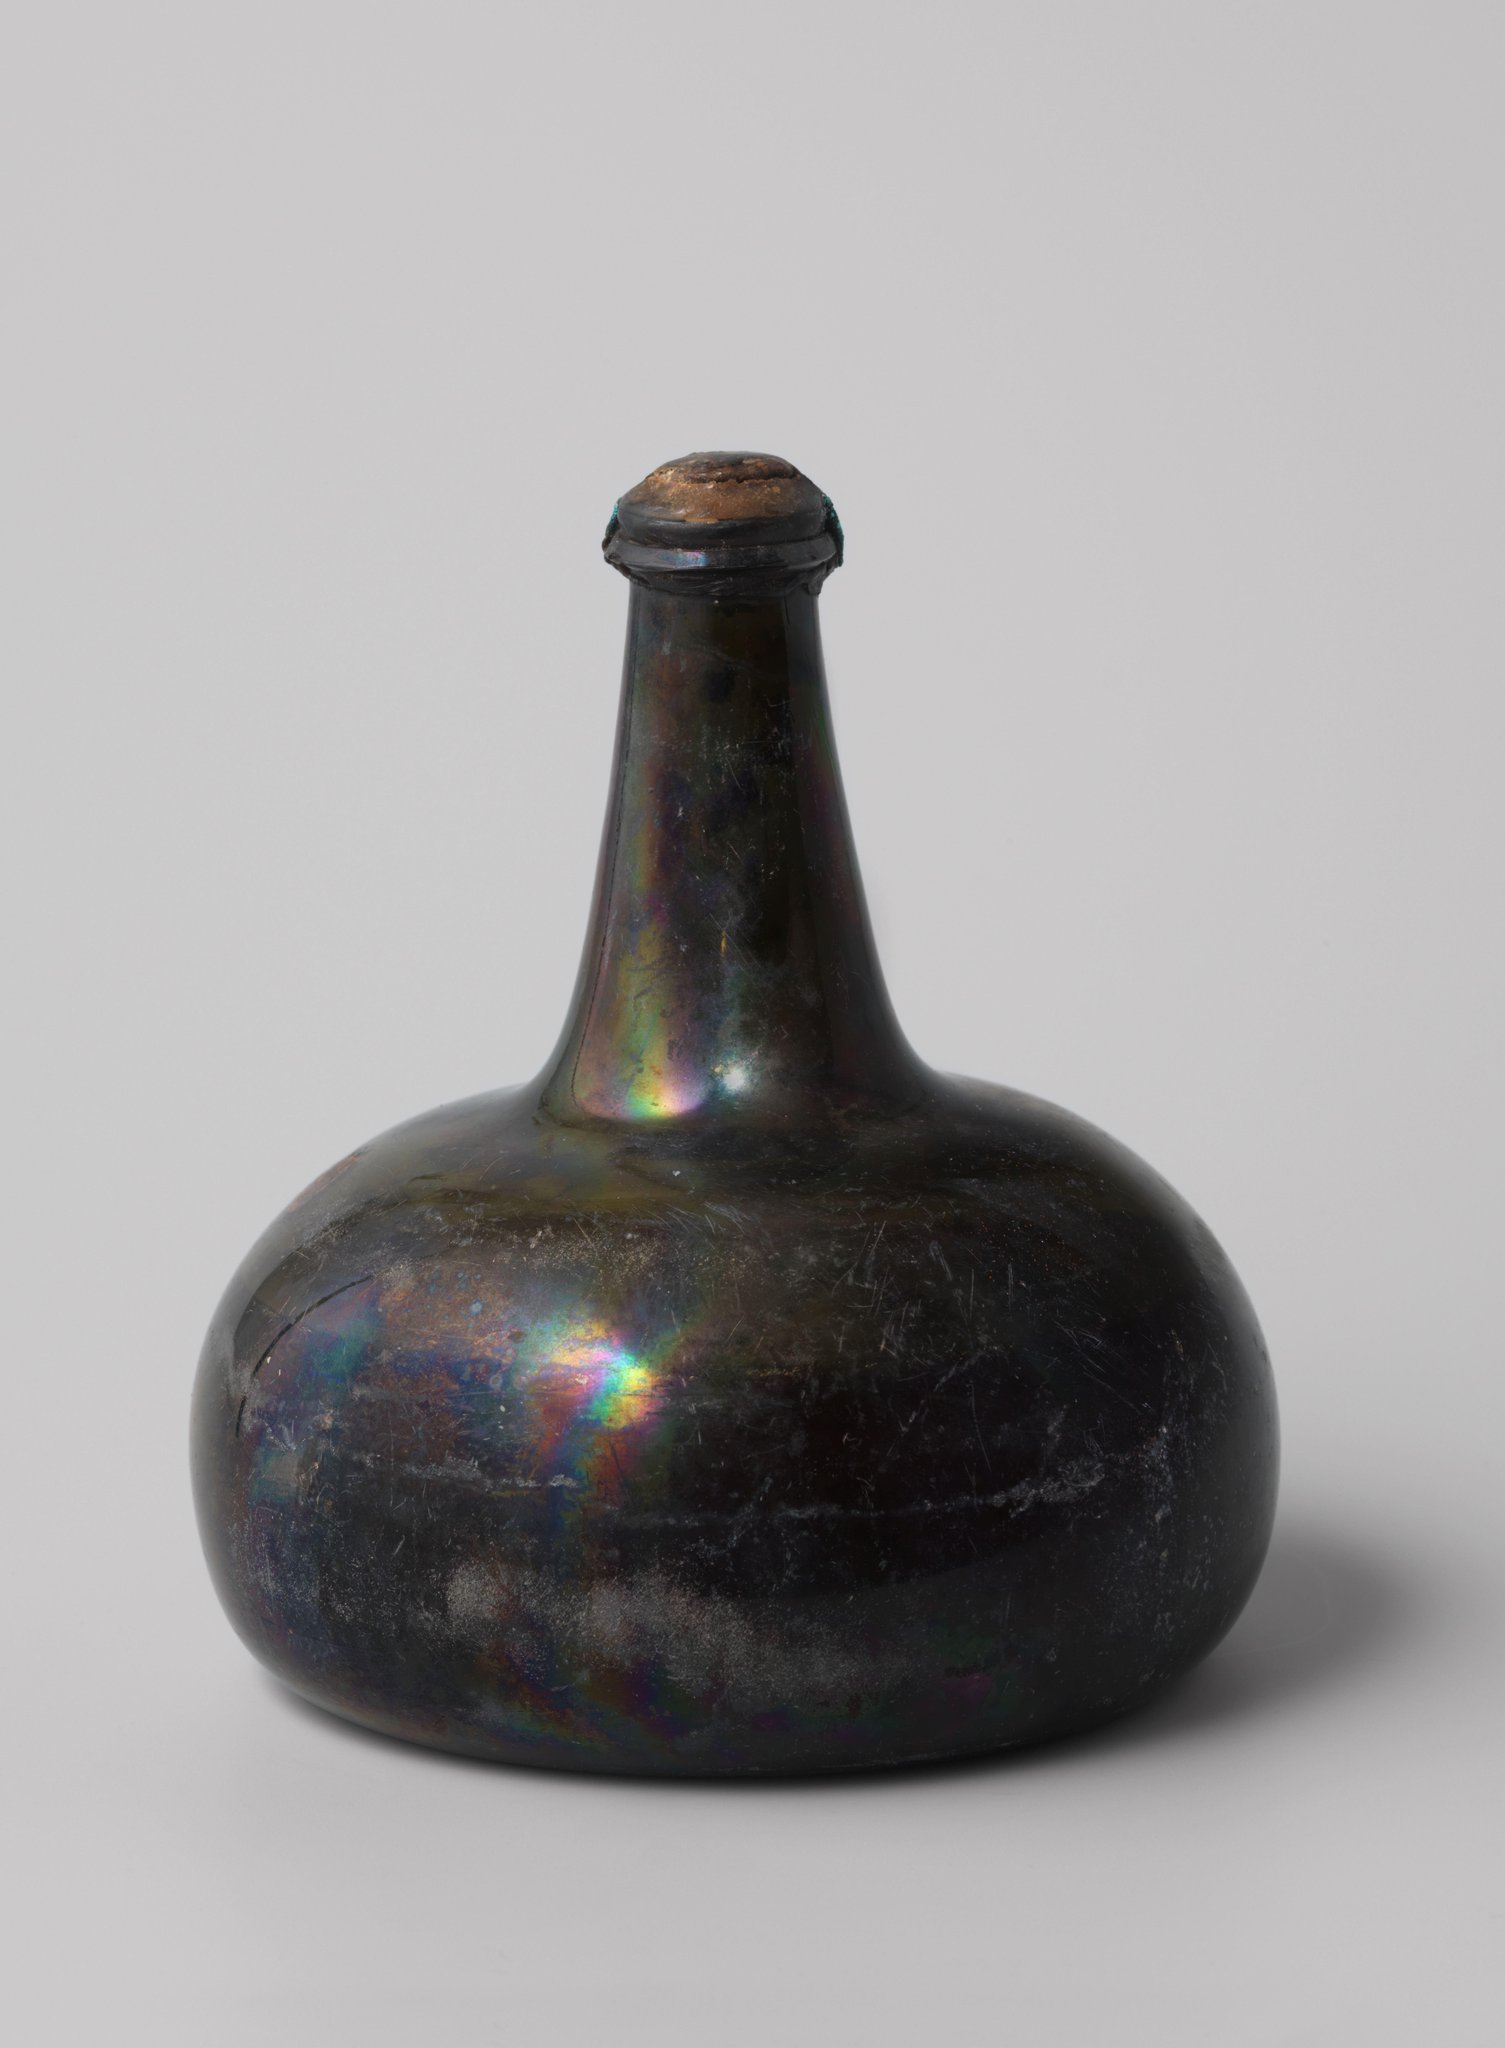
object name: wine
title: Wijnfles met wijn uit het wrak van de Oostindiëvaarder 't Vliegend Hart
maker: Anonymous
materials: cork, glass, lacquer, liquid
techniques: green glass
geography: netherlands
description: Uivormige wijnfles van groen glas gevuld met rode (port)wijn, afgesloten met kurk, draad en lak.